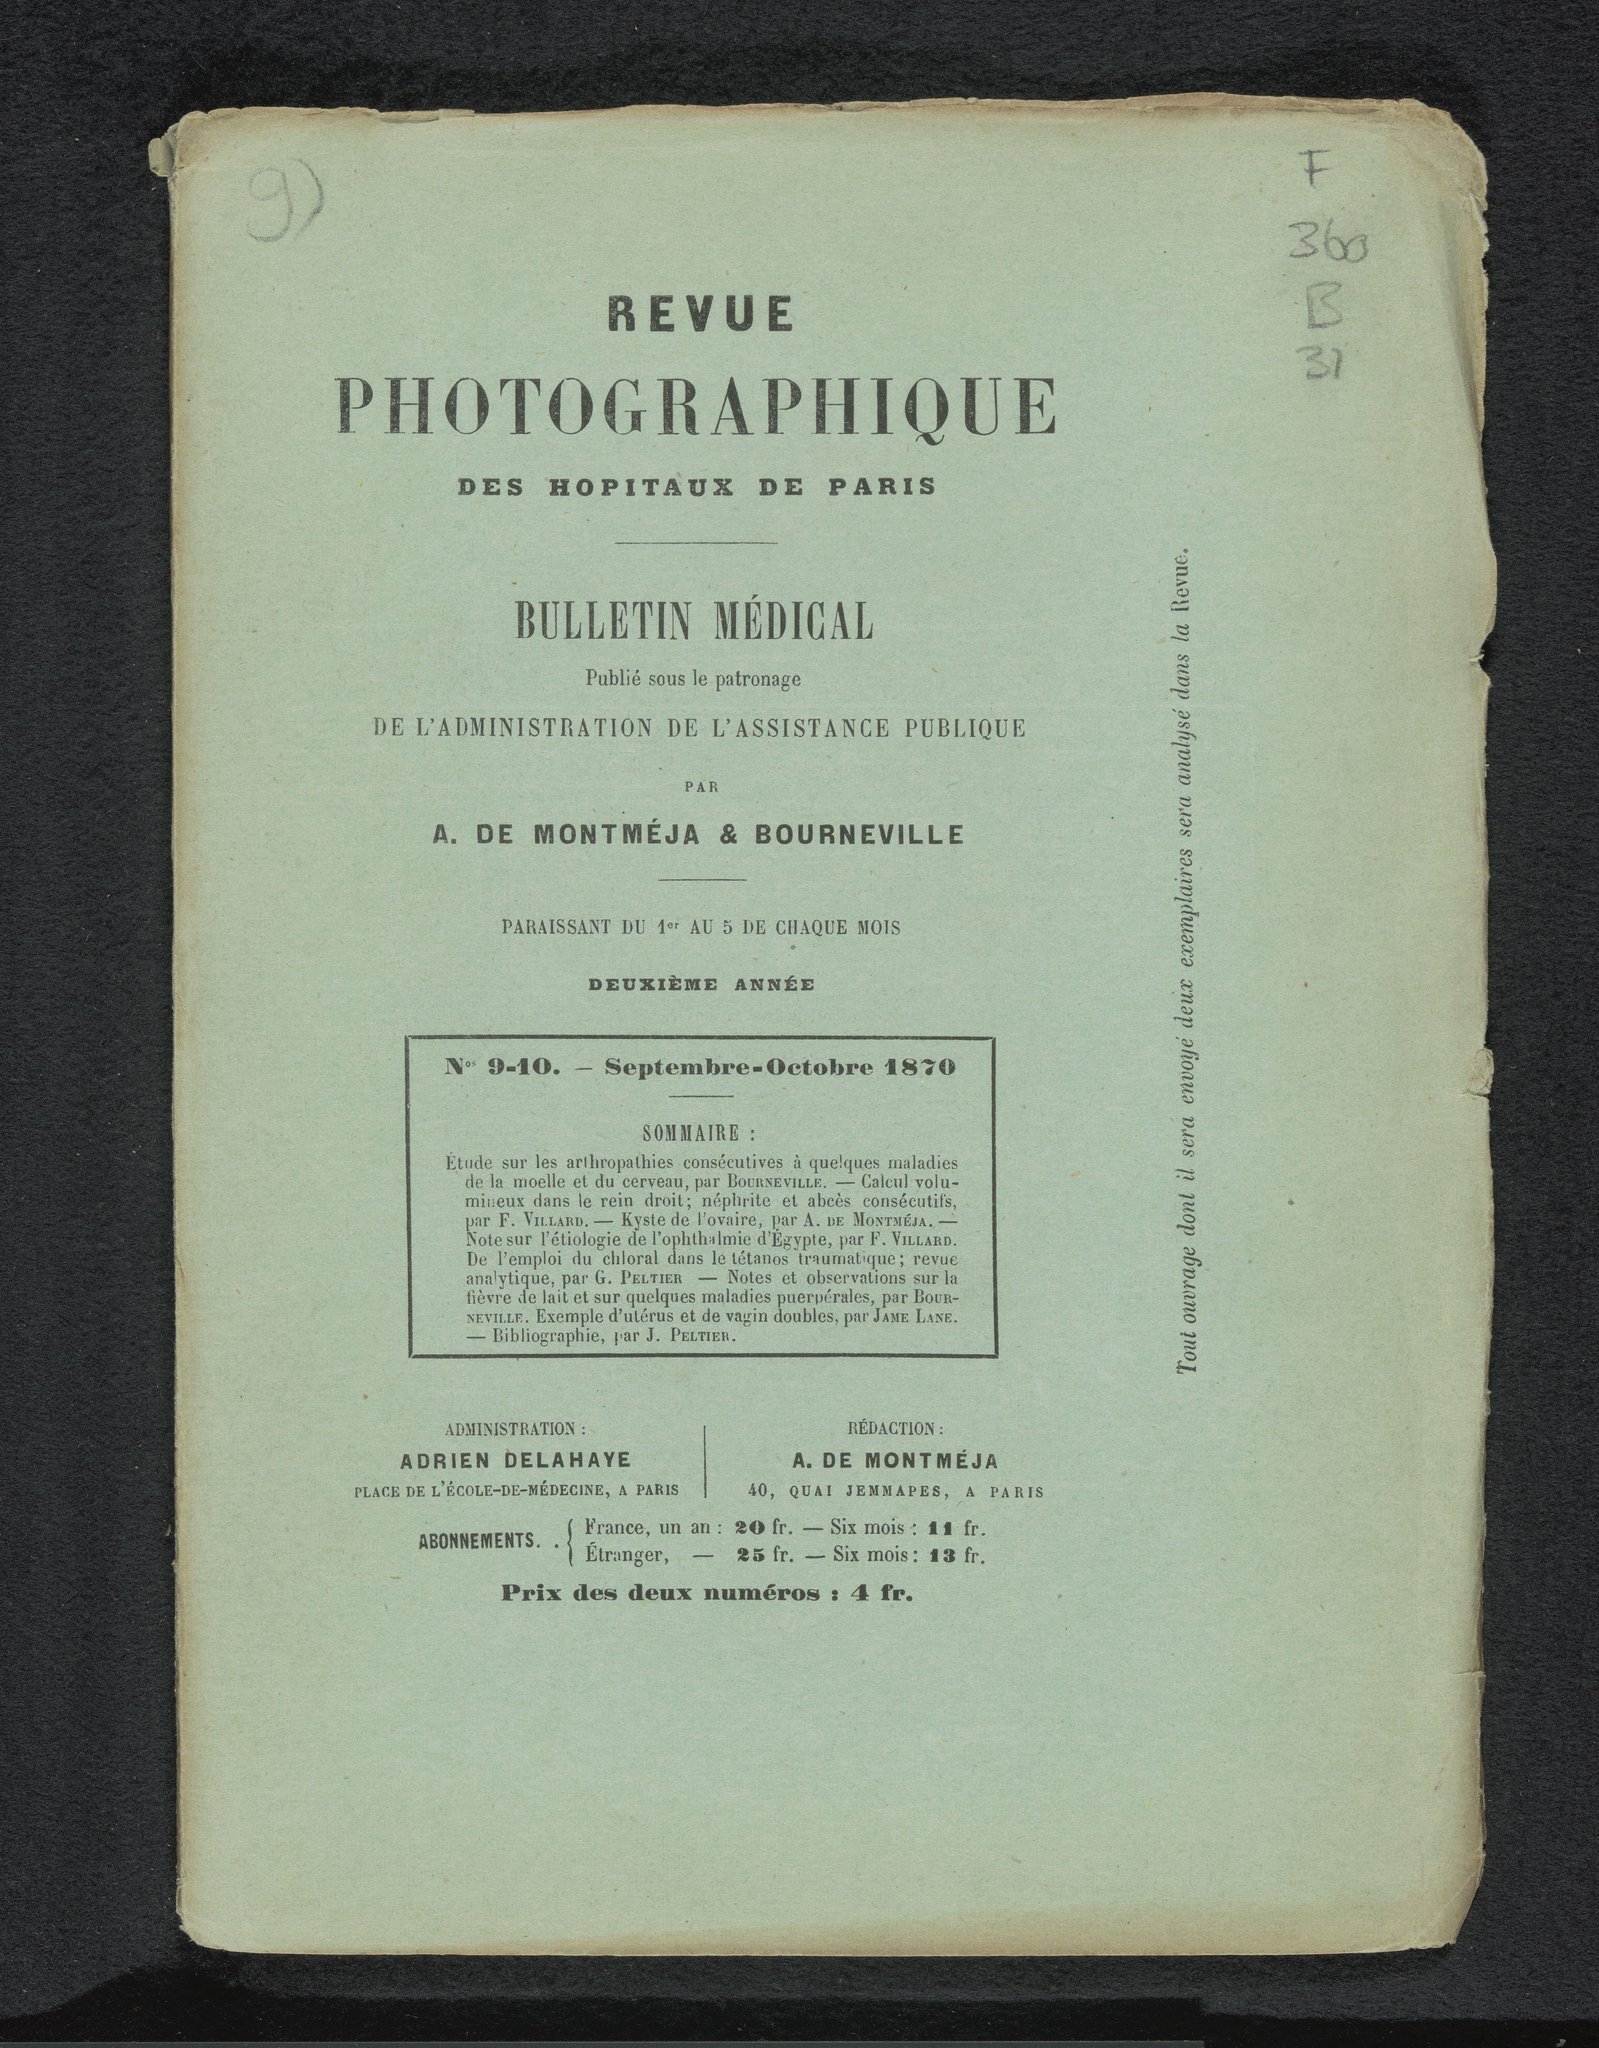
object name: magazine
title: Revue photographique des hôpitaux de Paris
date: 1870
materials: paper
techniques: printing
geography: paris